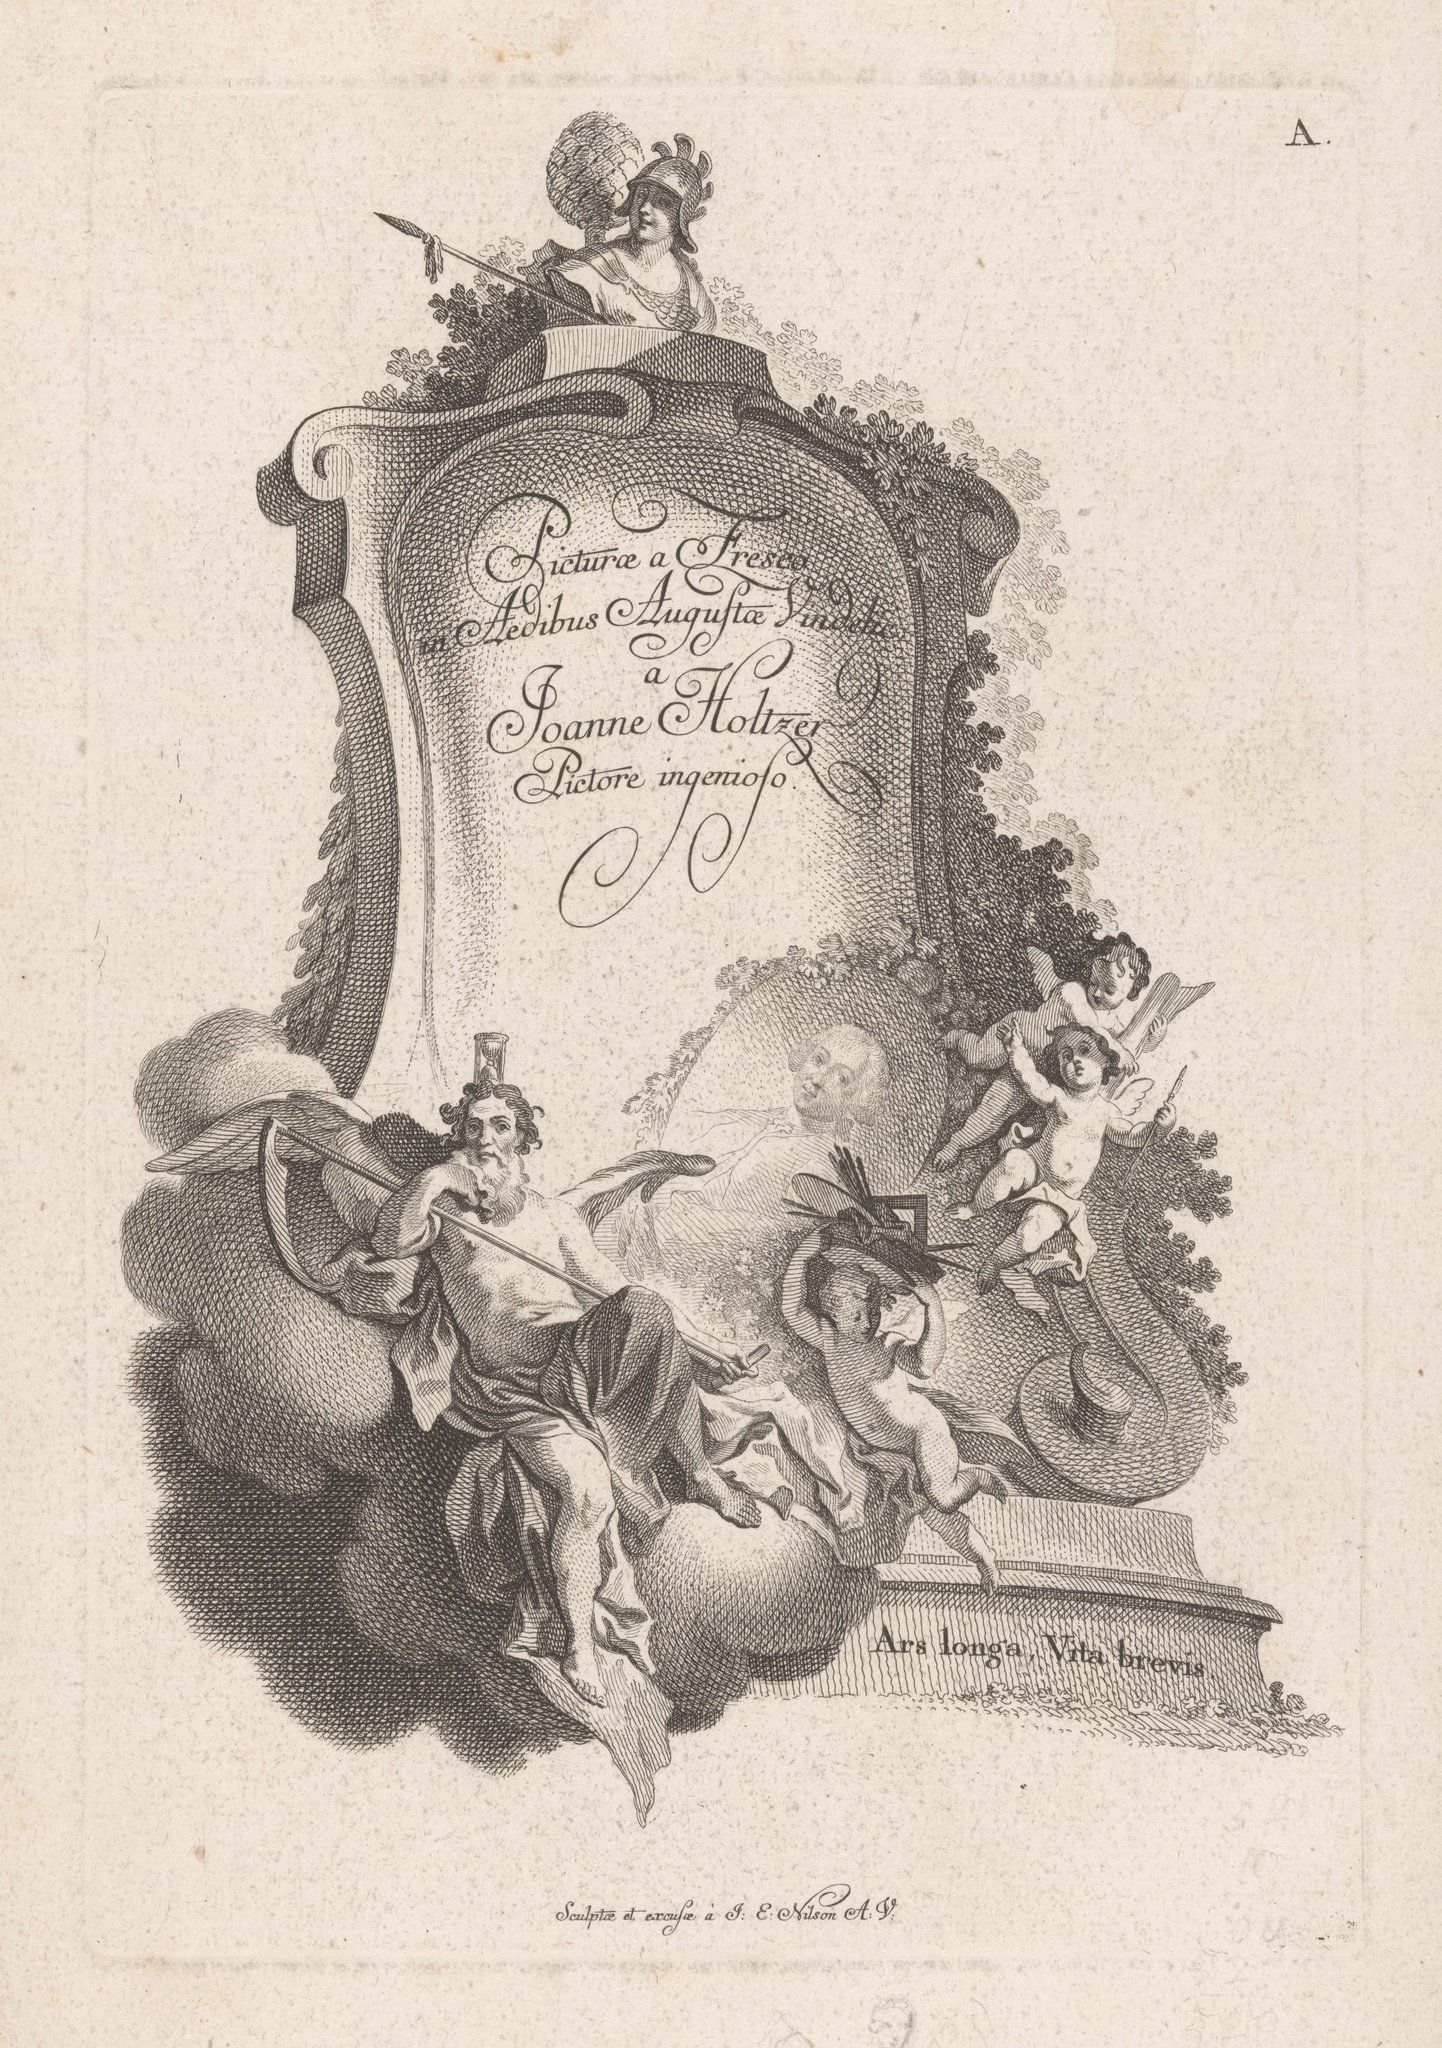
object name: ornament print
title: Picturae a Fresco in Aedibus Augustae Vindelic (...)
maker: johann esaias nilson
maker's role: draughtsman, print maker, publisher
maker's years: 1721-1788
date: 1765-1770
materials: paper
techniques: engraving, etching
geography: augsburg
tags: cupids together with attributes of the arts, sciences, etc., portrait, self-portrait of painter, ornament ~ cartouche, father time, man with wings and scythe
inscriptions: collector's mark: Lugt 2228, collector's mark: Lugt 2760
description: Cartouche met de serietitel en een ovaal medaillon met een portret van de schilder Johann Evangelist Holzer. Rechts omgeven drie gevleugelde putti met schildersattributen het portret. Links zit Vader Tijd met een zeis en zandloper op wolken. Een buste van Minerva bekroont de cartouche.